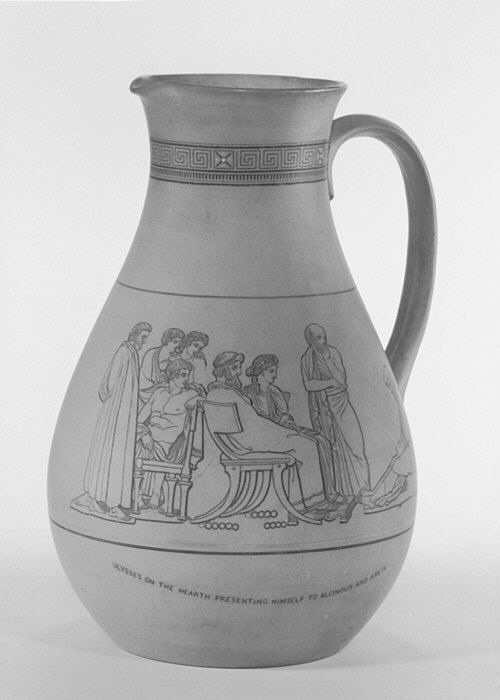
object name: ewer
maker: bishops waltham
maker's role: factory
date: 1862-1867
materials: stoneware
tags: men,women